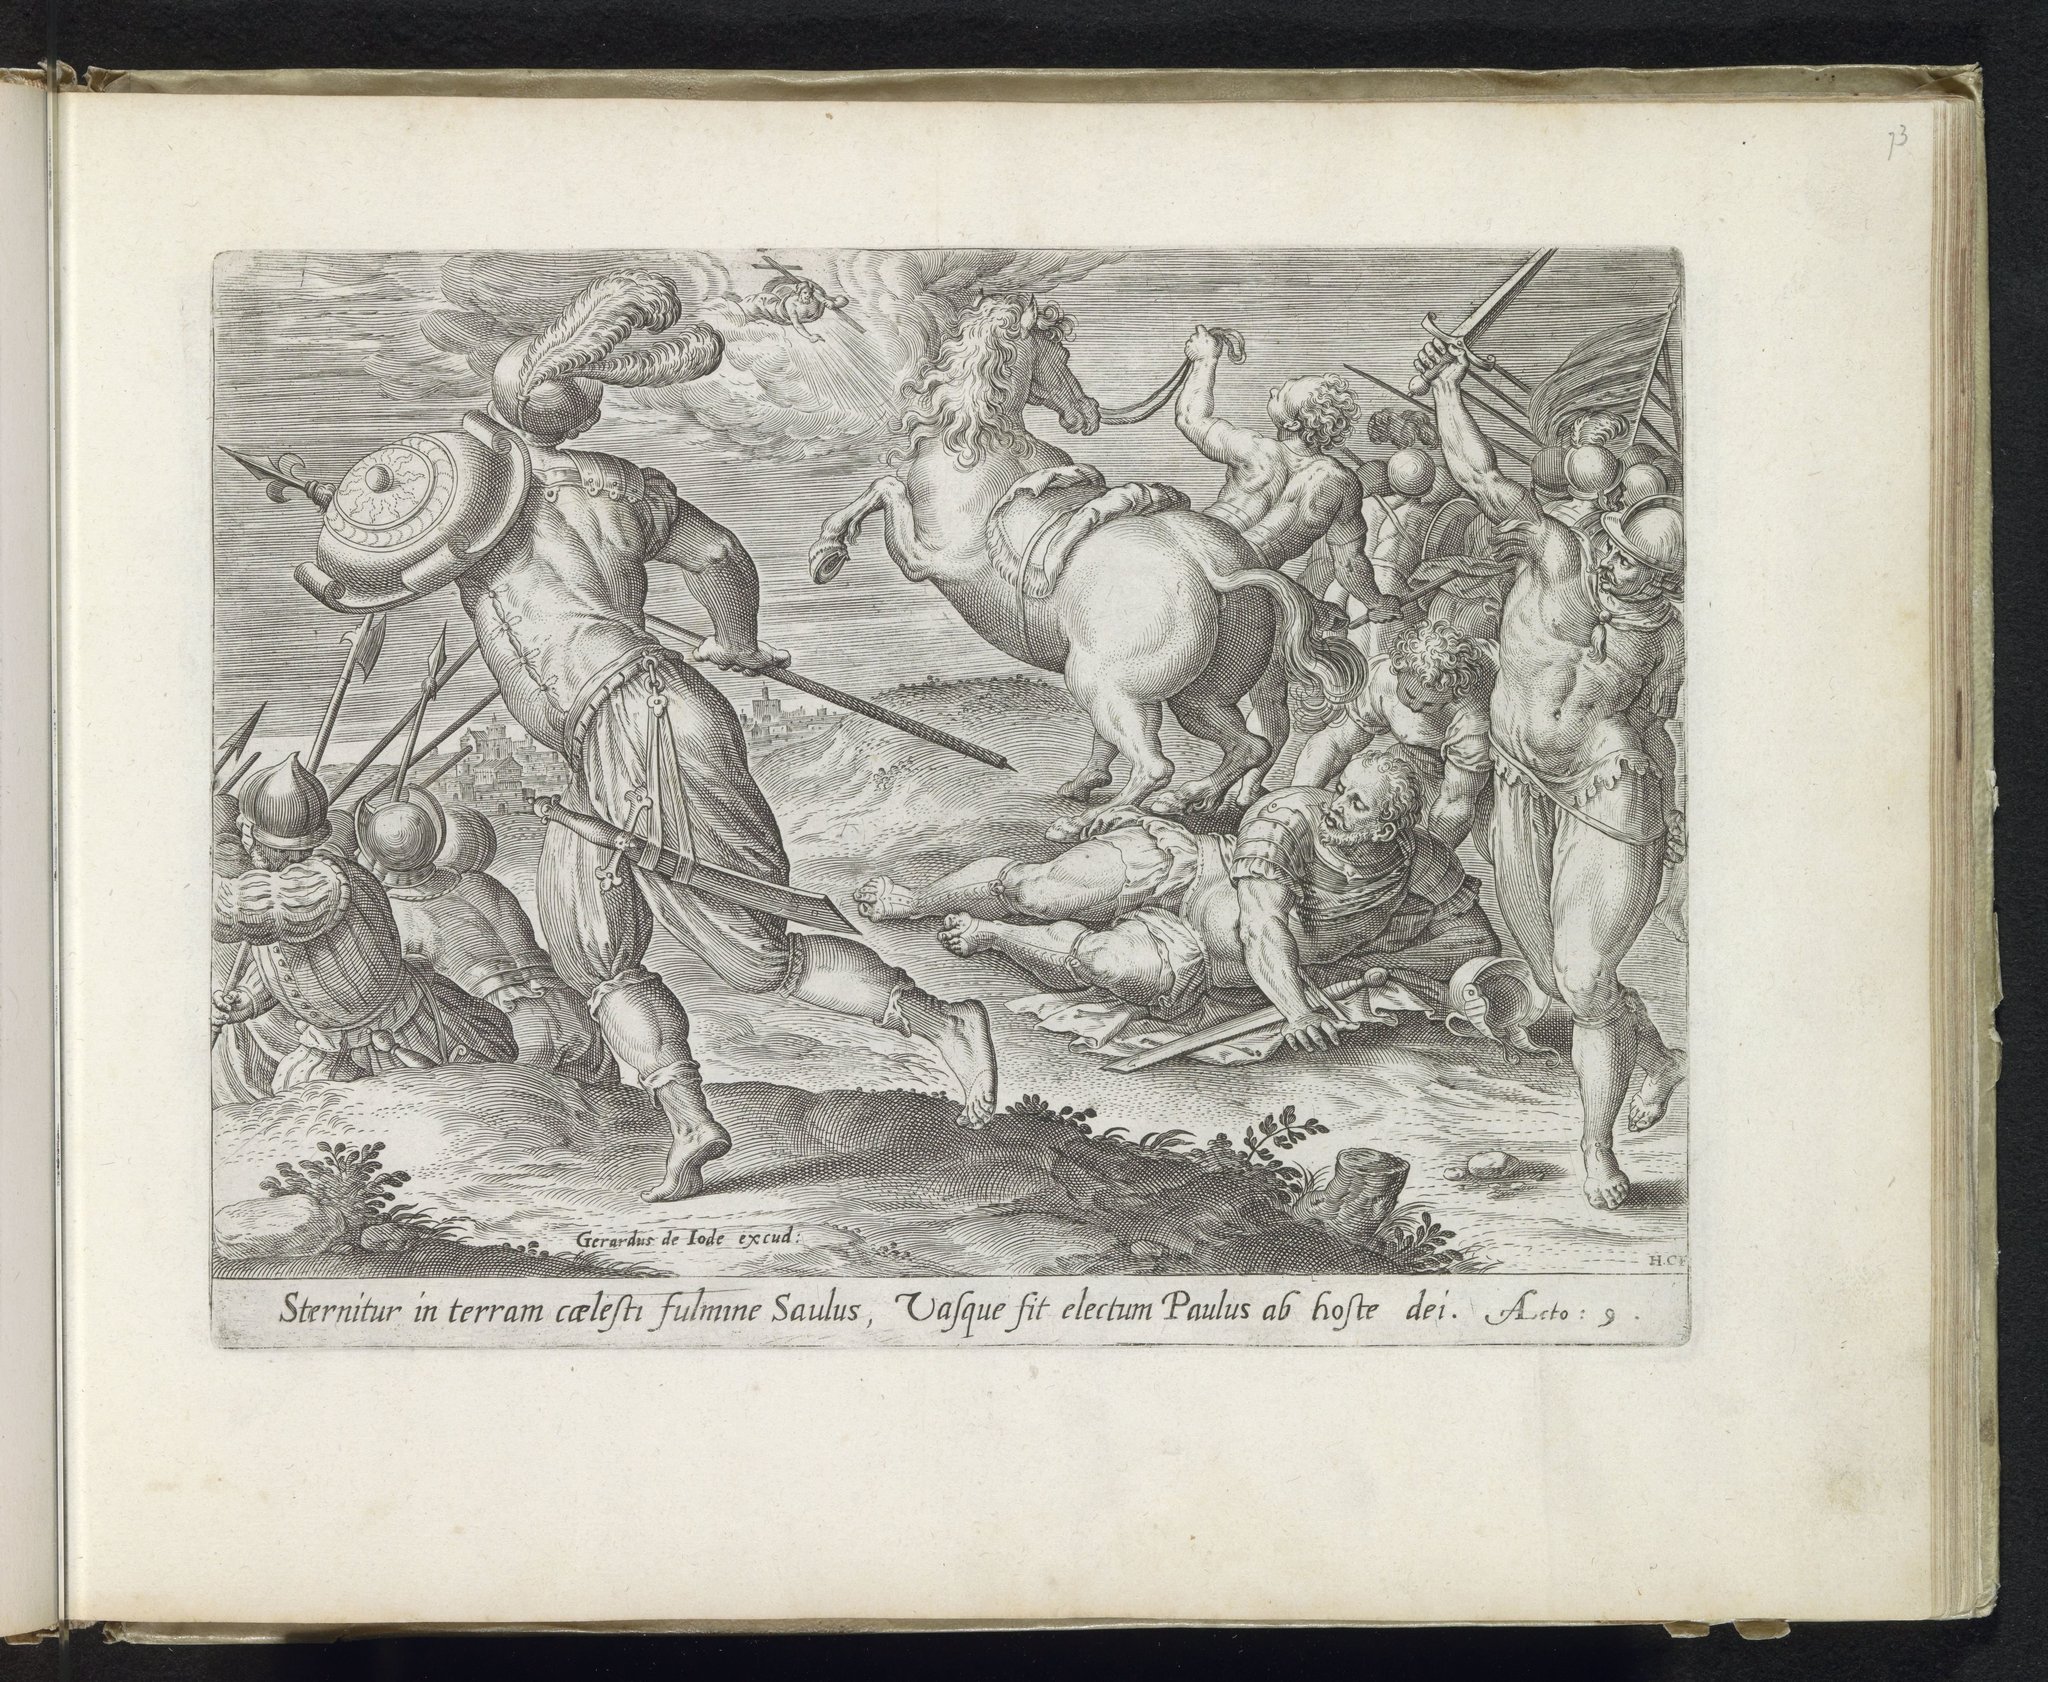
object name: print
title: Bekering van Paulus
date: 1585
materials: paper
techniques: engraving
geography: antwerp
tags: on the way to damascus christ appears to saul, who falls from his horse and is blinded by the light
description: Paulus valt van zijn paard als hij wordt verblind door de verschijning van Christus op de weg naar Damascus. Zijn mannen schrikken en trekken hun wapens. Onder de voorstelling een verwijzing in het Latijn naar de Bijbeltekst in Hand. 9. Deze prent maakt deel uit van een album.